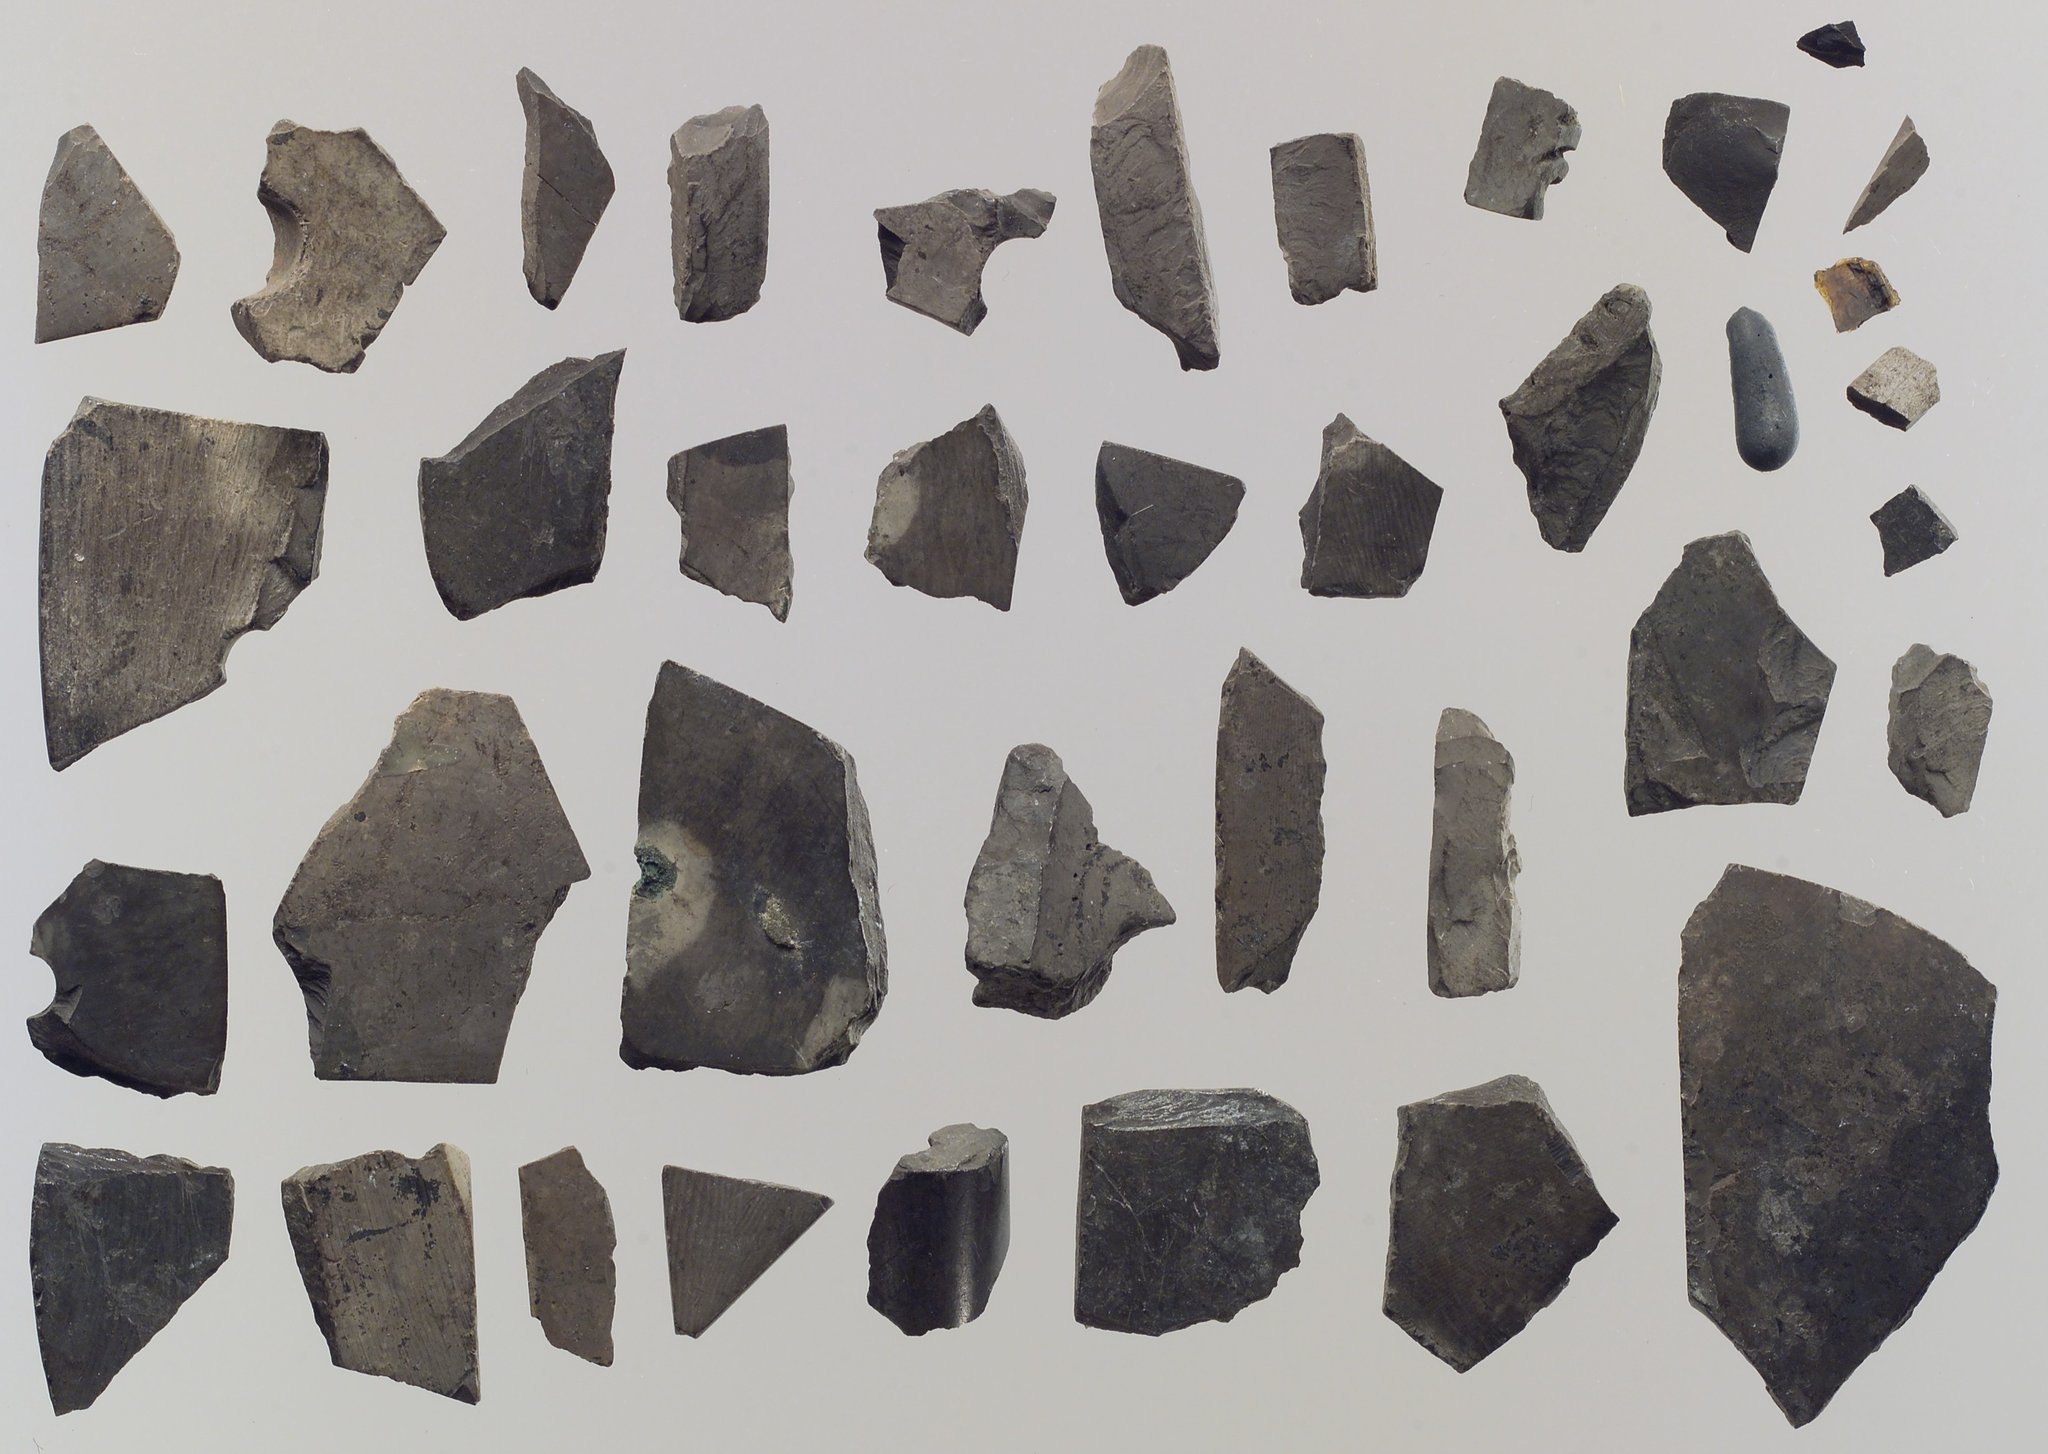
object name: furniture element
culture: assyrian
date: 1800-1701 BCE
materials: ivory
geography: anatolia